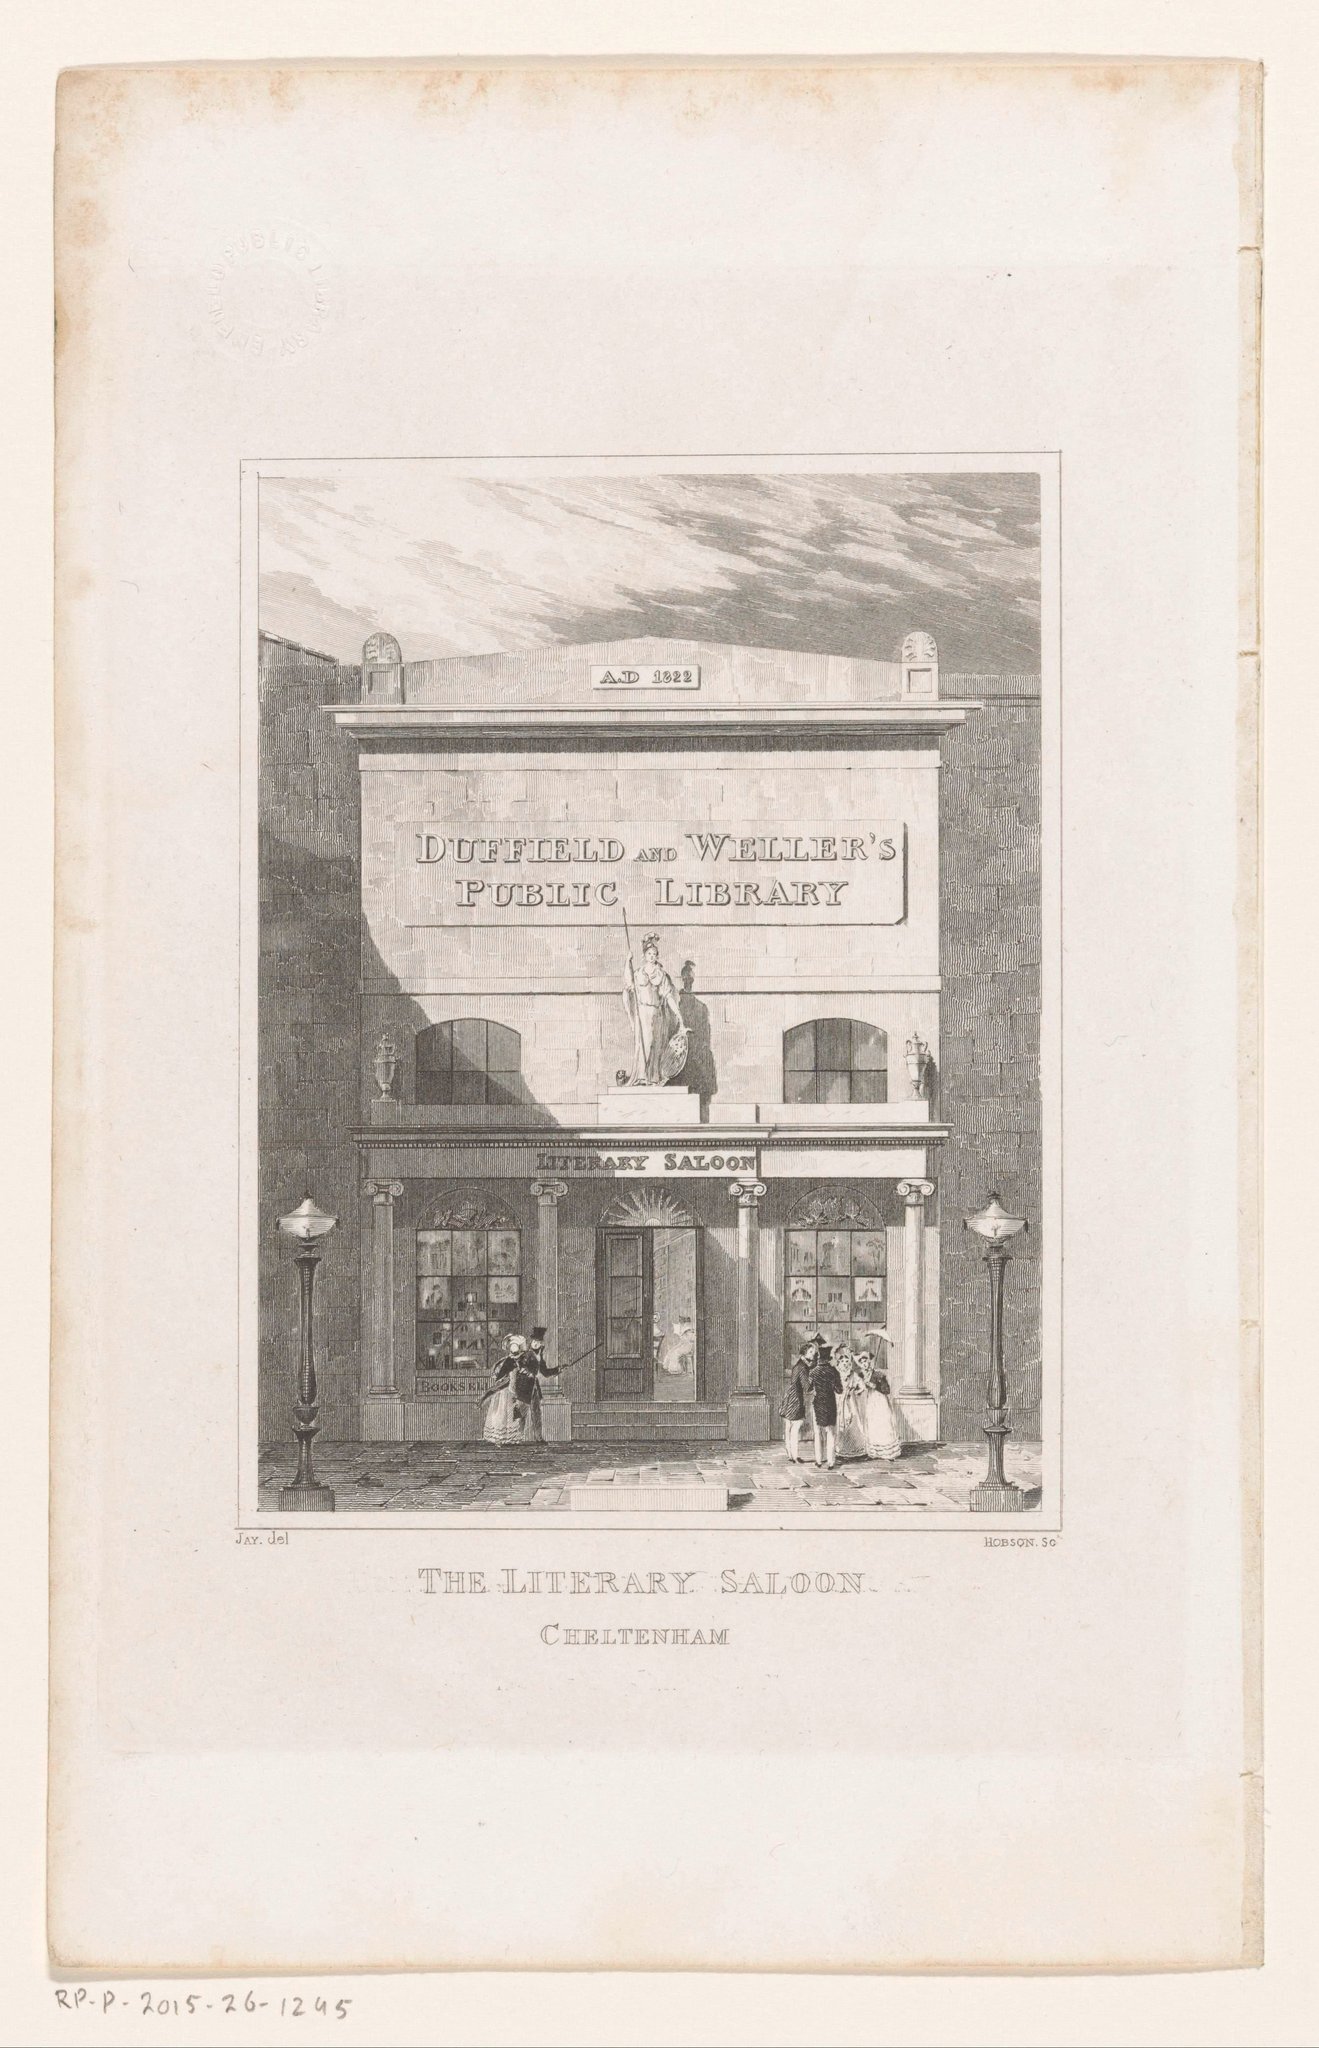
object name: book illustration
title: The Literary Saloon Cheltenham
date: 1826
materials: paper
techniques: etching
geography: cheltenham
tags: façade (of house or building), public library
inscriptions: collector's mark: Lugt 4779, check stamp: ‘Enfield Public Library’, collector's mark: Lugt 2228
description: Op de gevel de naam van de bibliotheek, de stichtingsdatum (1822) en een beeld van Minerva. Aan weerszijden van de deur bevinden zich twee etalages met boeken en prenten. Op de voorgrond twee lantaarnpalen.